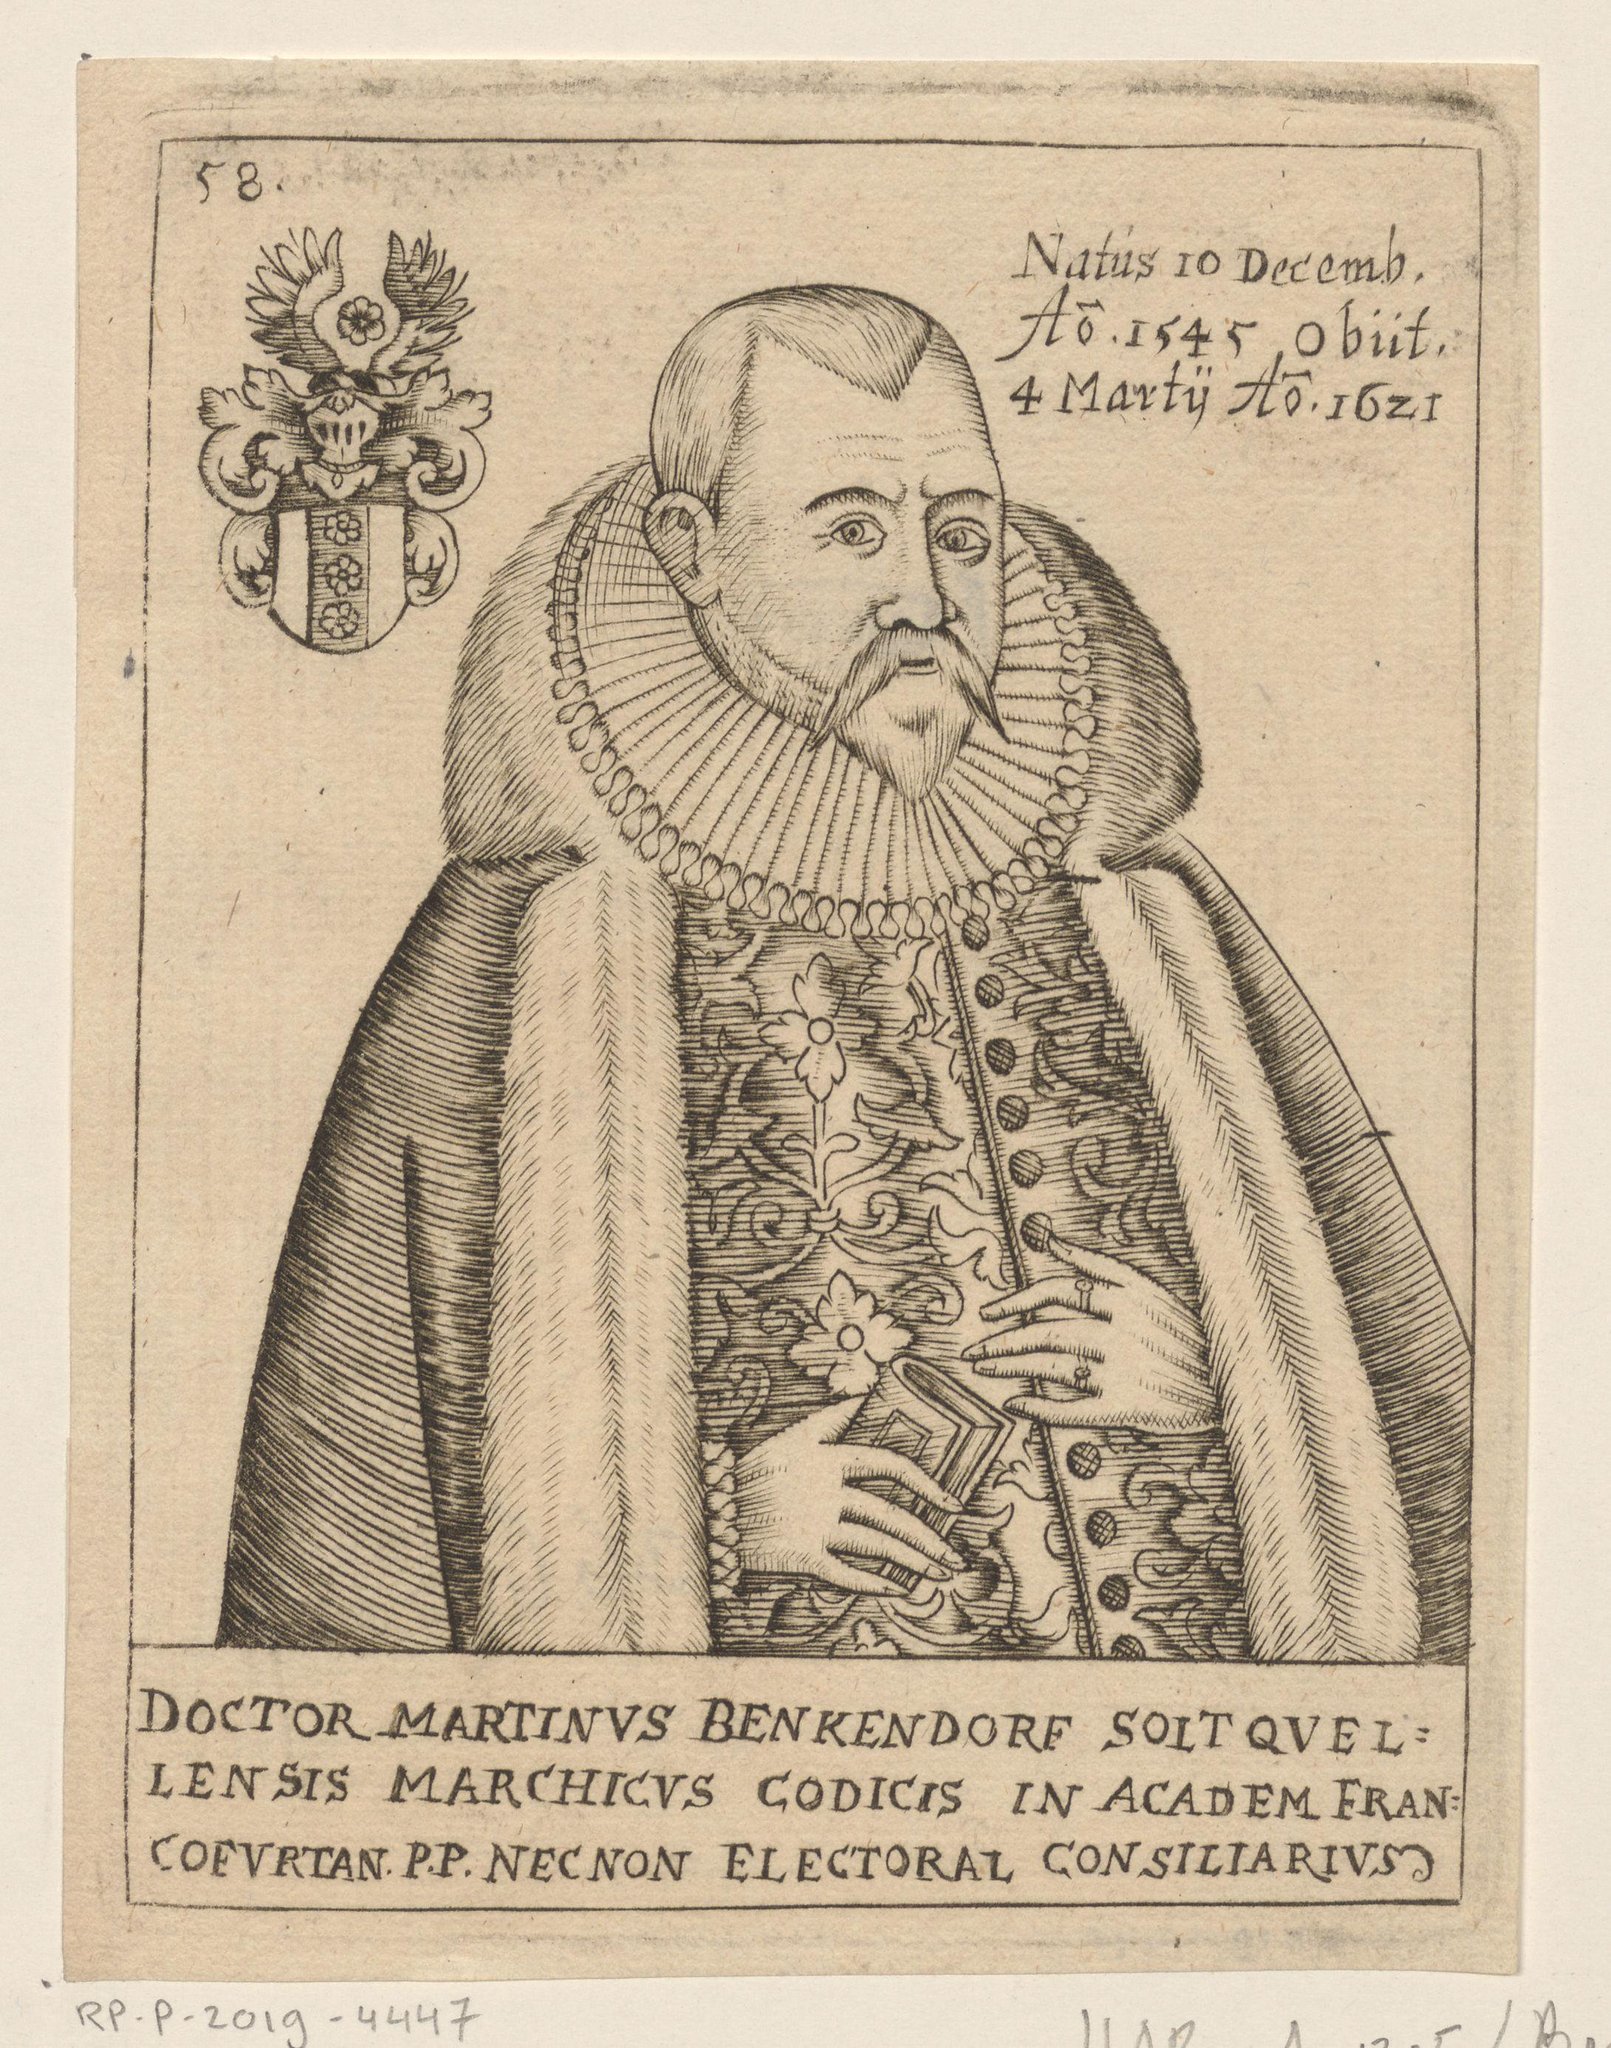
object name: print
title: Portret van Martin Benckendorf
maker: Anonymous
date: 1671-1751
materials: paper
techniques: engraving, etching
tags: historical persons, book, armorial bearing, heraldry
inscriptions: collector's mark: Lugt 2228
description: De prent is uitgegeven als onderdeel van een serie. Later is de prent mogelijk ook als boekillustratie gebruikt in: Küster, Georg Gottfried. Martin Friedrich Seidels Bilder-Sammlung in welcher hundert, gröstentheils in der Mark Brandenburg (…). Berlijn: Buchladen bey der Real-Schule, 1751. Het is onduidelijk tot welke uitgave de huidige prent behoort.